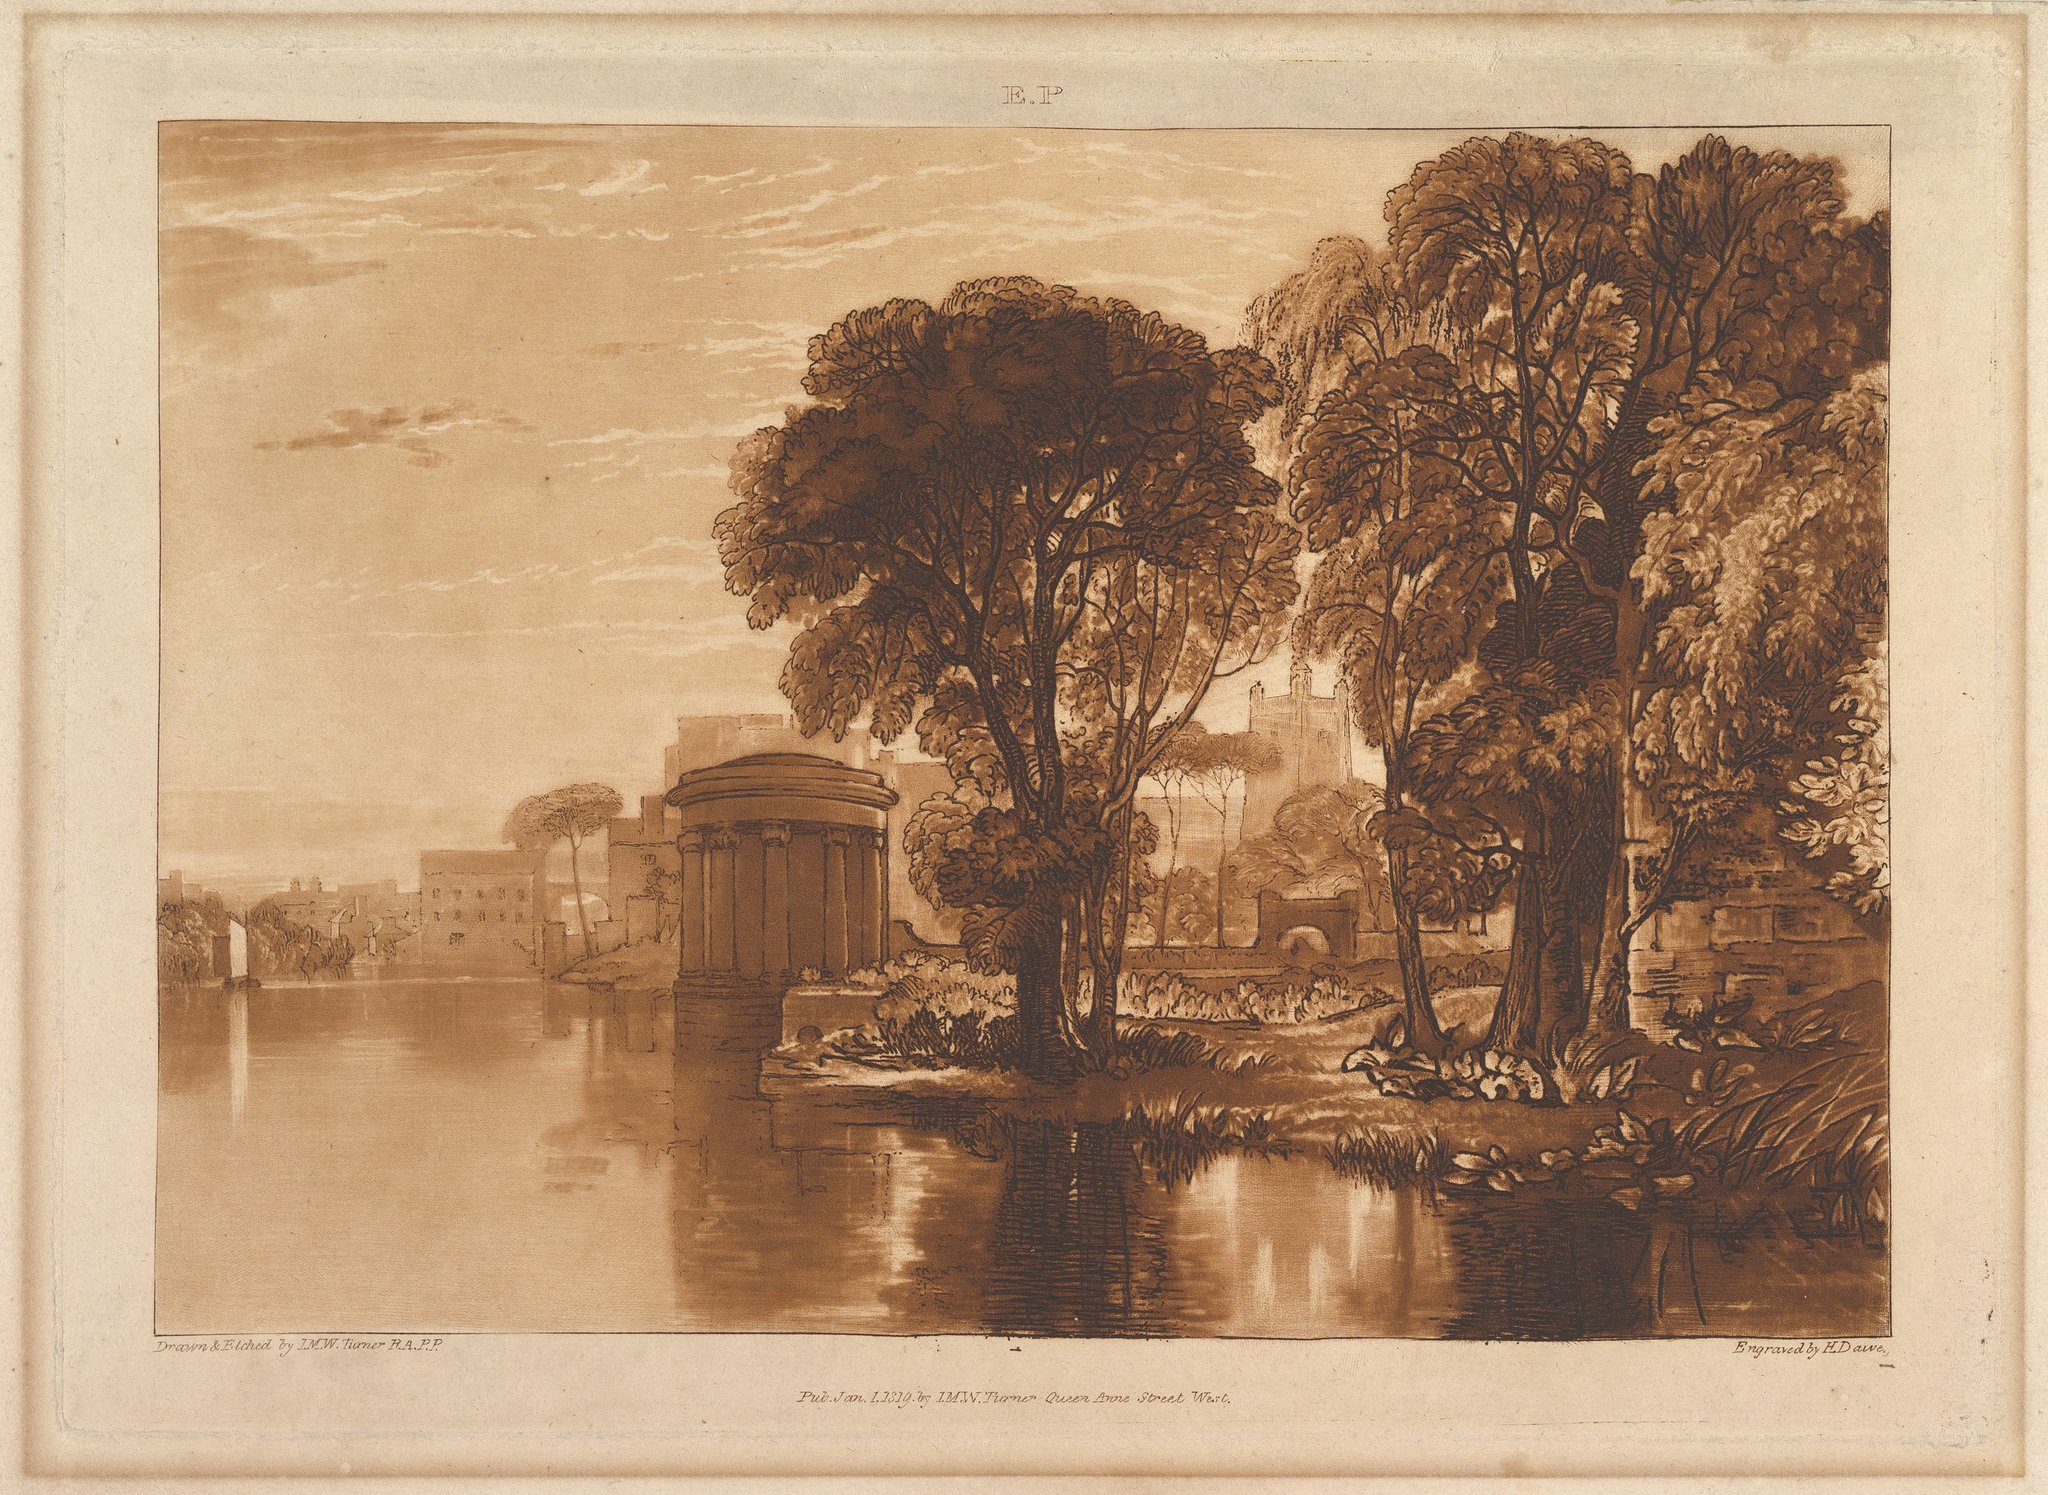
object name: print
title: Isleworth (Liber Studiorum, part XIII, plate 63)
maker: joseph mallord william turner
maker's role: artist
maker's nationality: british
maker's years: 1775-1851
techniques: etching, mezzotint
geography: london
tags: landscapes